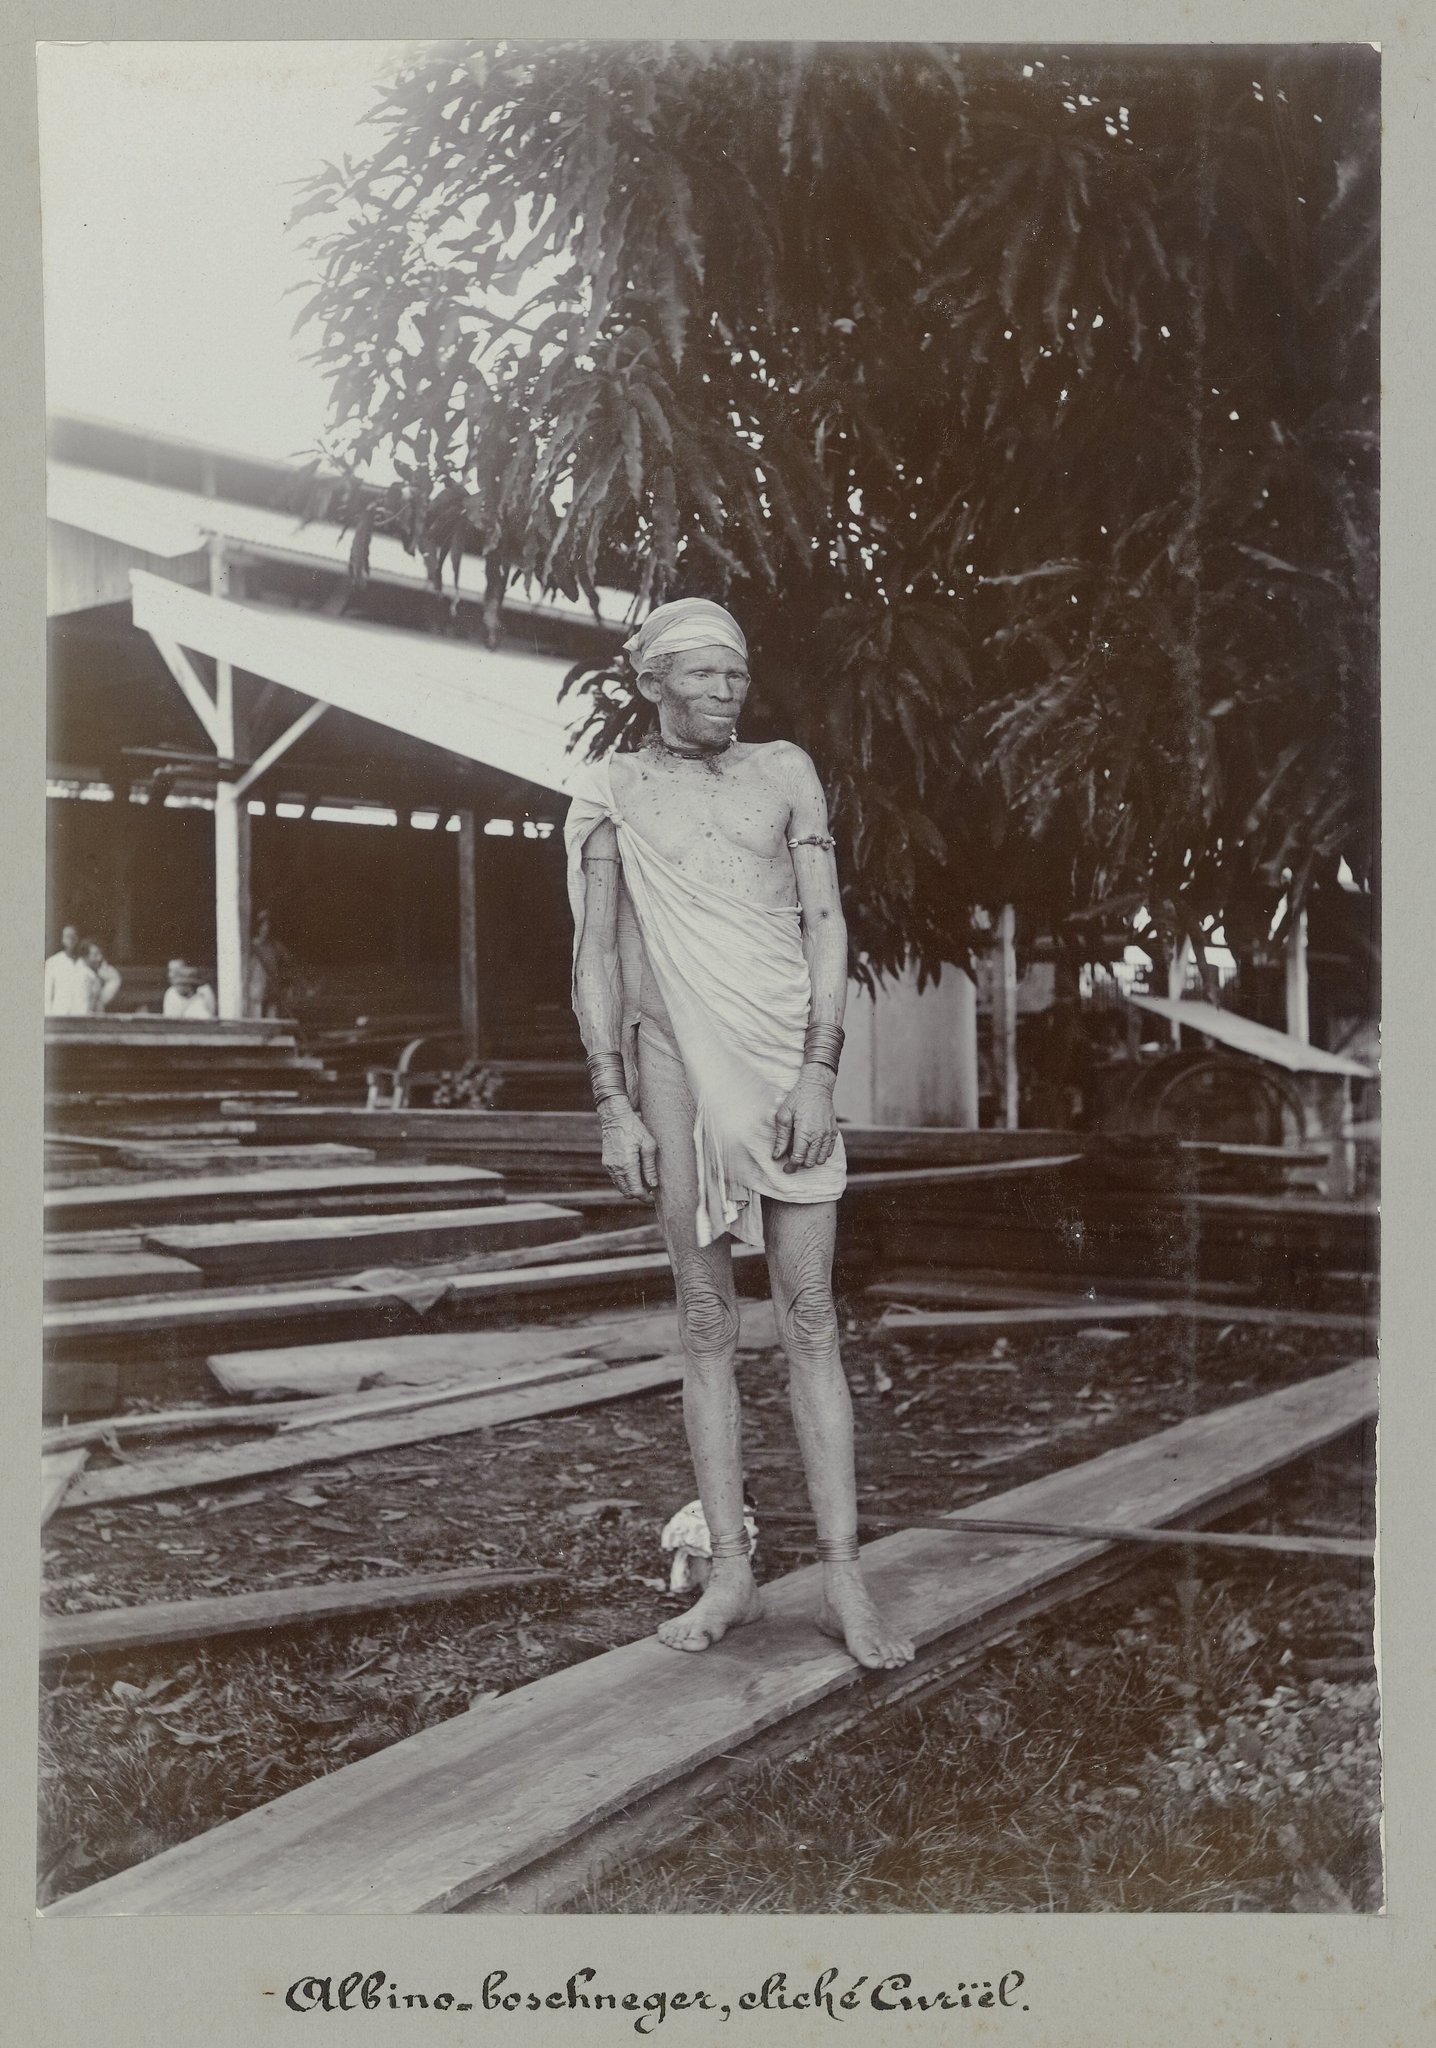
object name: photograph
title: Marron met albinisme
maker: augusta curiel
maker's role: fotograaf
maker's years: 1873-1937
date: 1900-1913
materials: photographic support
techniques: collodion silver print, gelatin silver print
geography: suriname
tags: (person with) albinism, suriname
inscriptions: inscription: ‘Albino-boschneger, cliché Curiël.’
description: Een Marron obiaman, een genezer, met albinisme, staand poserend. Onderdeel van het fotoalbum Souvenir de Voyage (deel 3), over het leven van de familie Dooyer in en rond de plantage Ma Retraite in Suriname in de jaren 1906-1913.